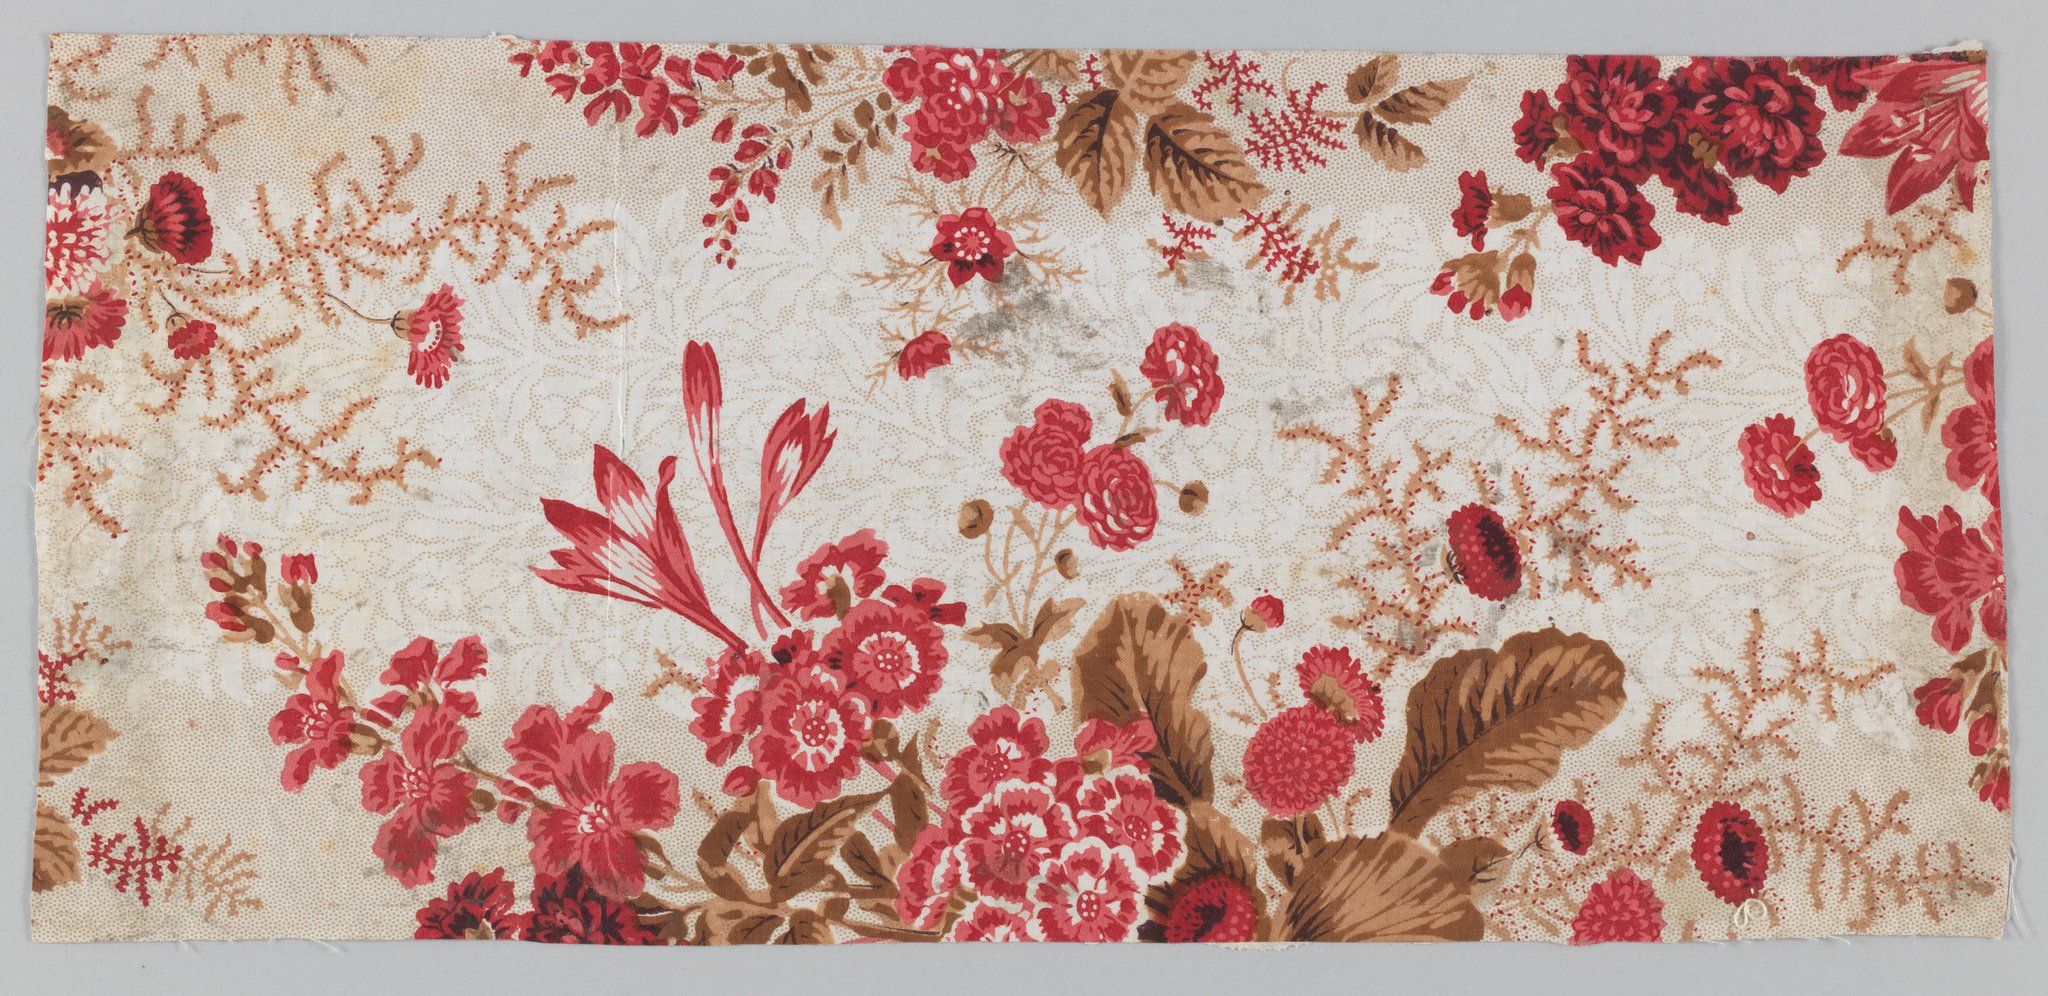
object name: piece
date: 1801-1900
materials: cotton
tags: flowers